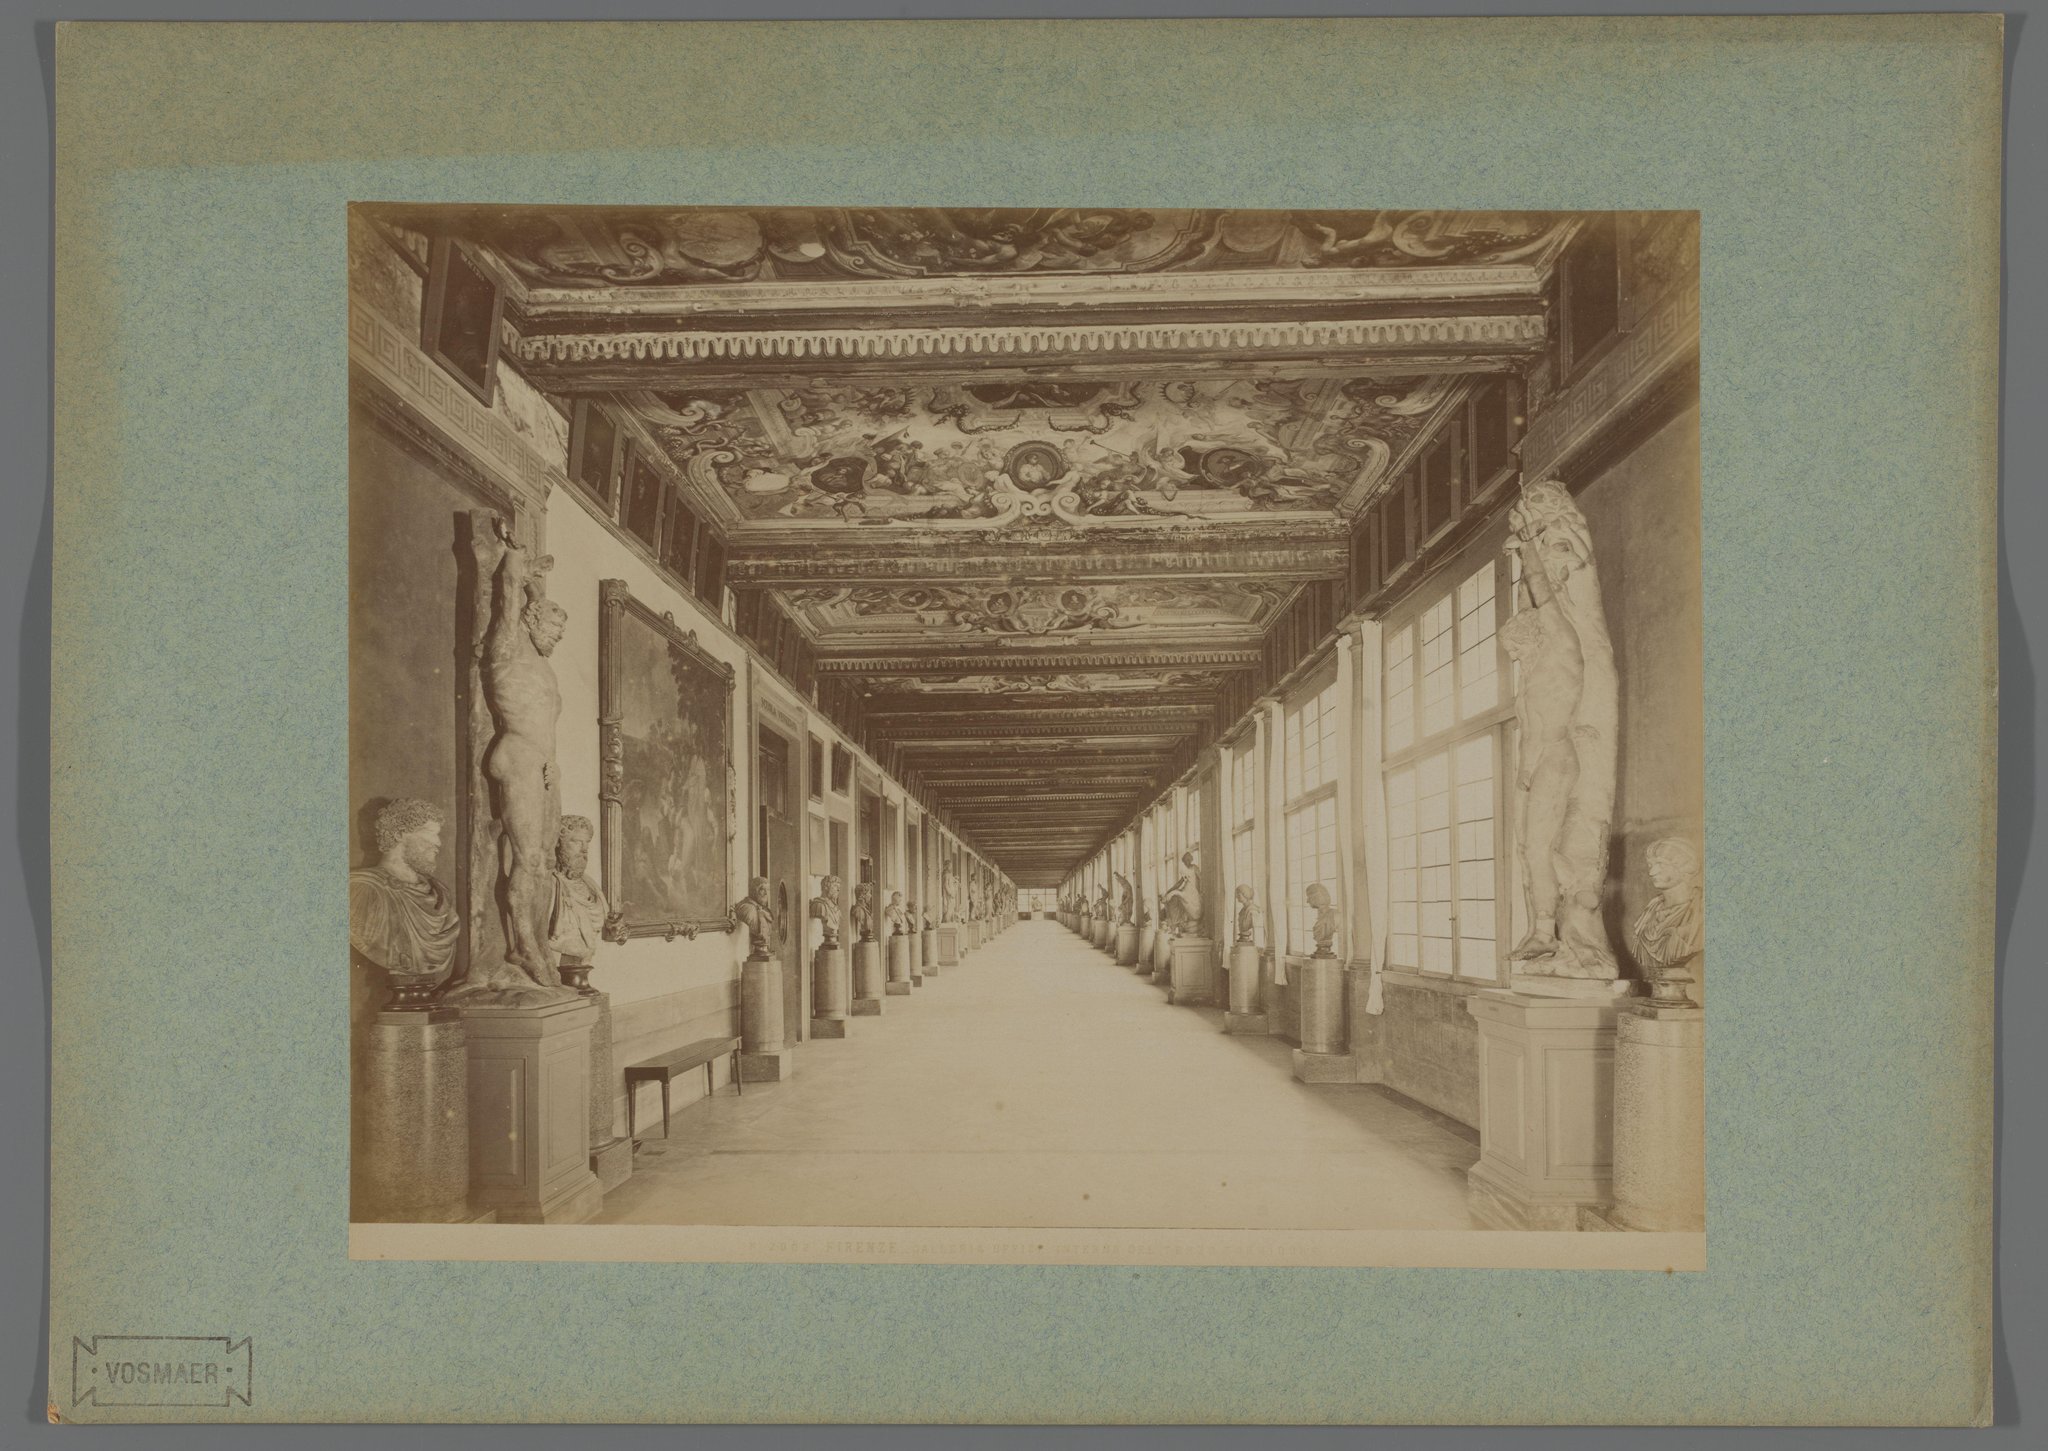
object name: photograph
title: Galleria Uffizi. Interno del Terzo Corridoio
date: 1857-1900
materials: cardboard, paper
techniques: albumen print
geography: florence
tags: gallery of sculptures, piece of sculpture, reproduction of a piece of sculpture, permanent exhibition, museum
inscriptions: number: ‘No. 2002.’, collector's mark: ‘VOSMAER’